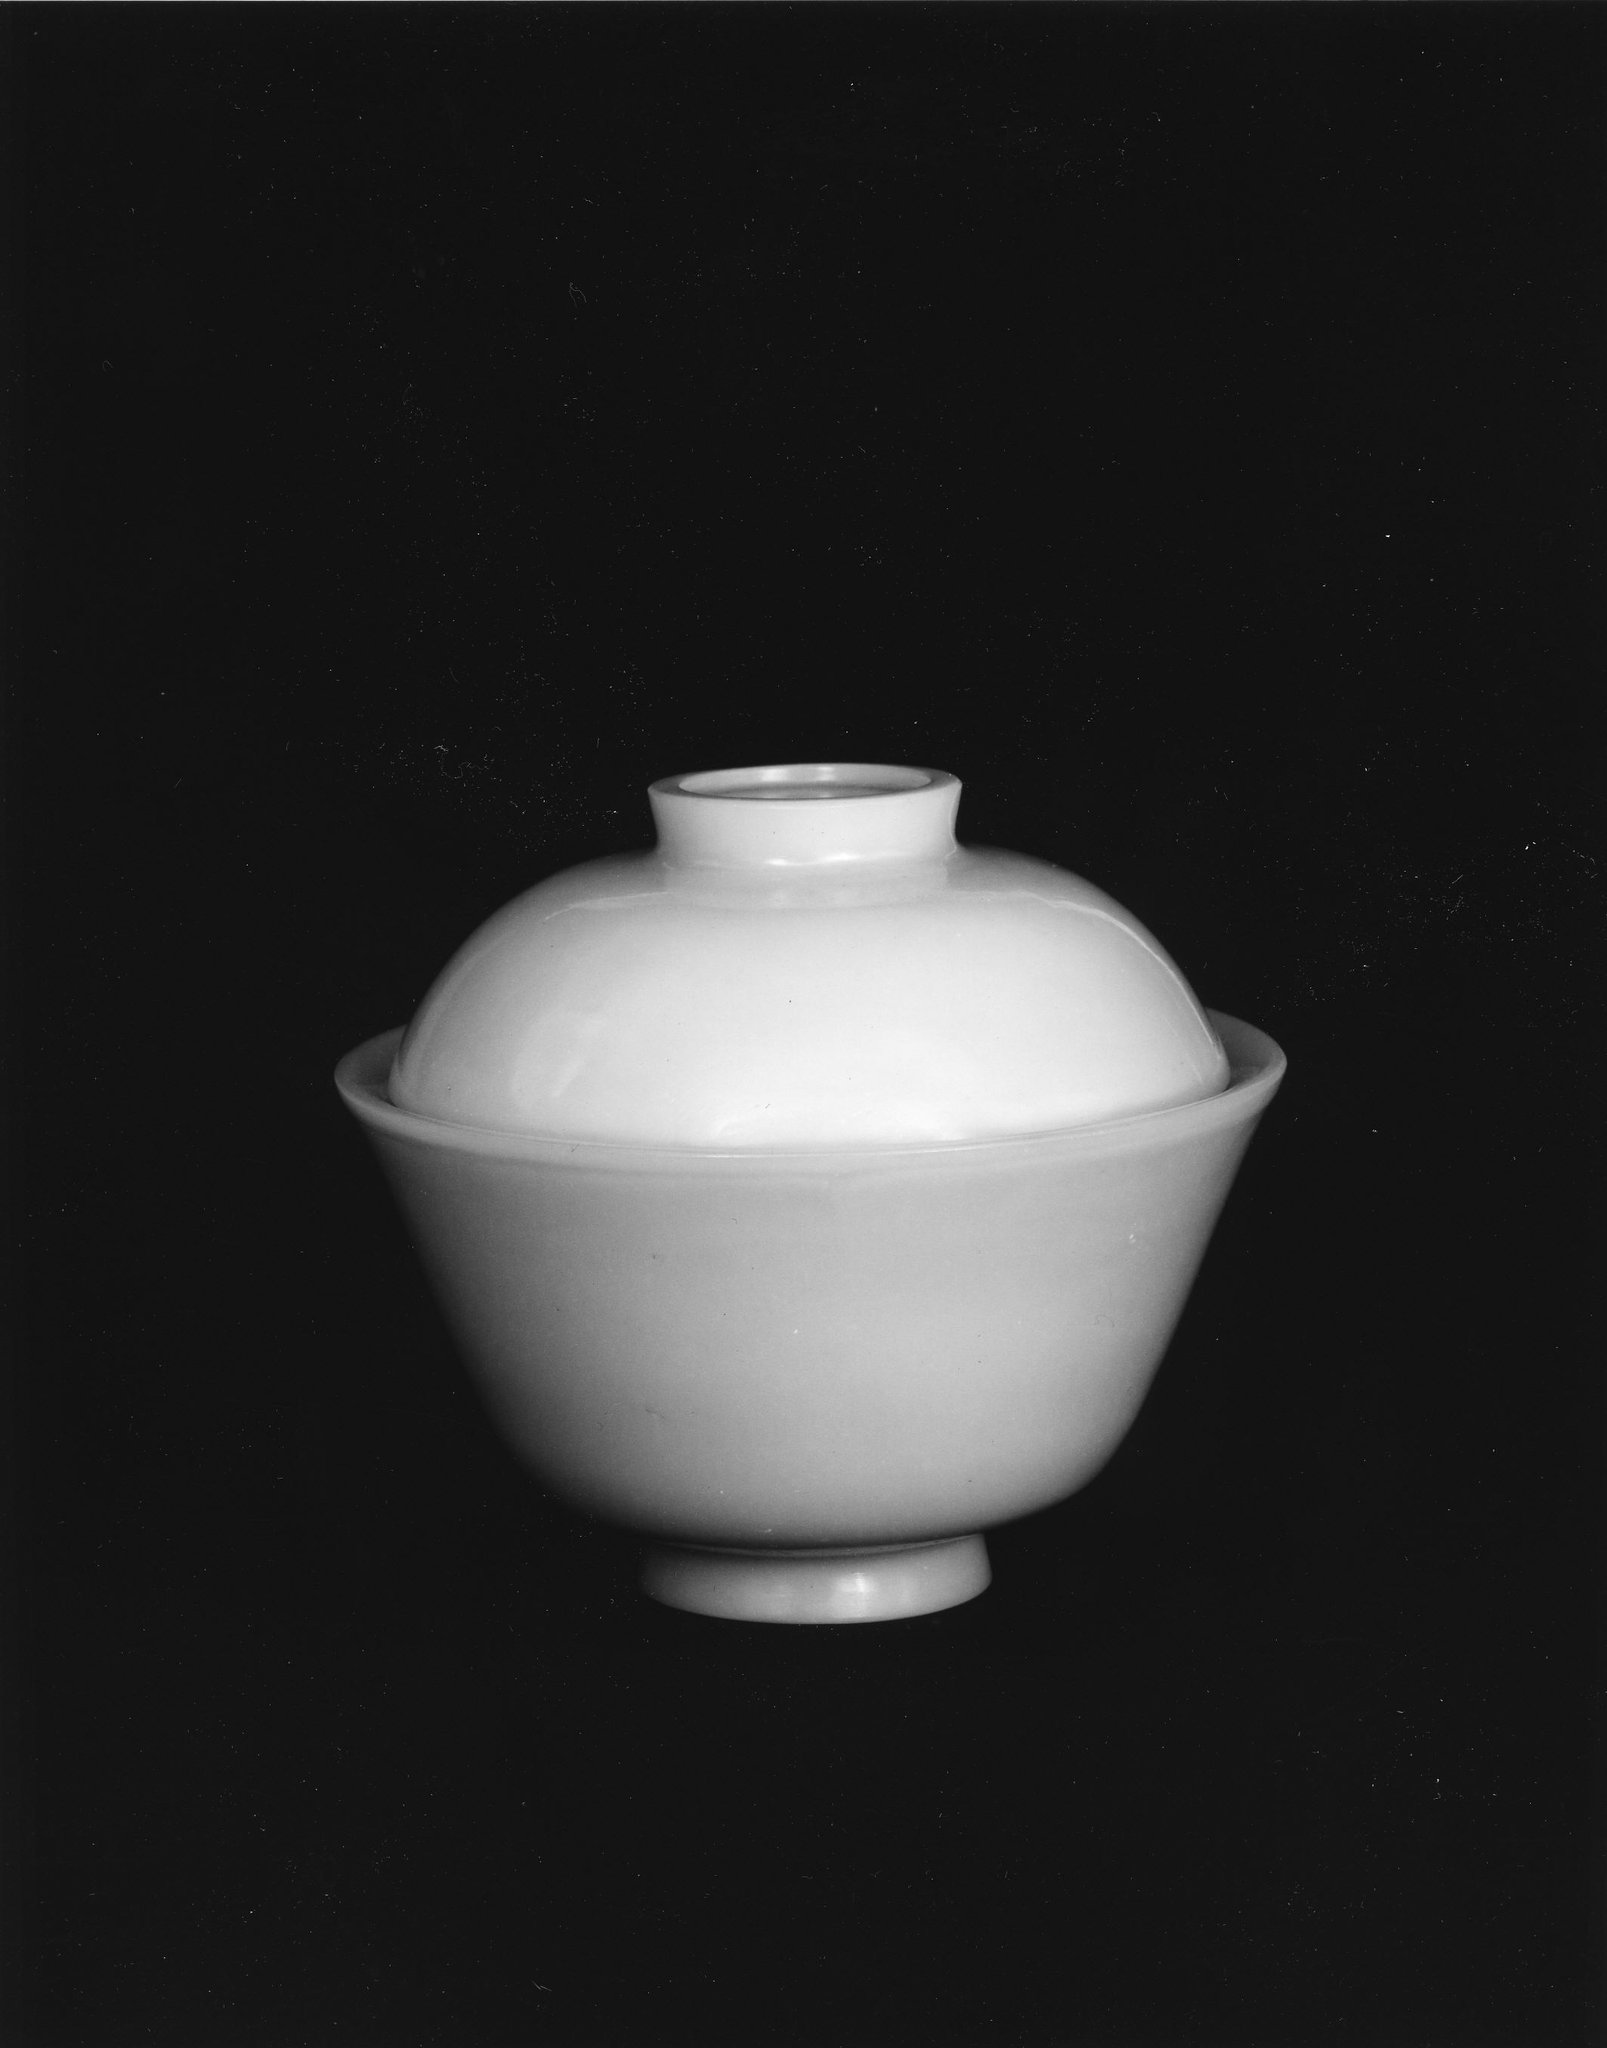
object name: covered bowl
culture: chinese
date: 1644-1911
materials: glass